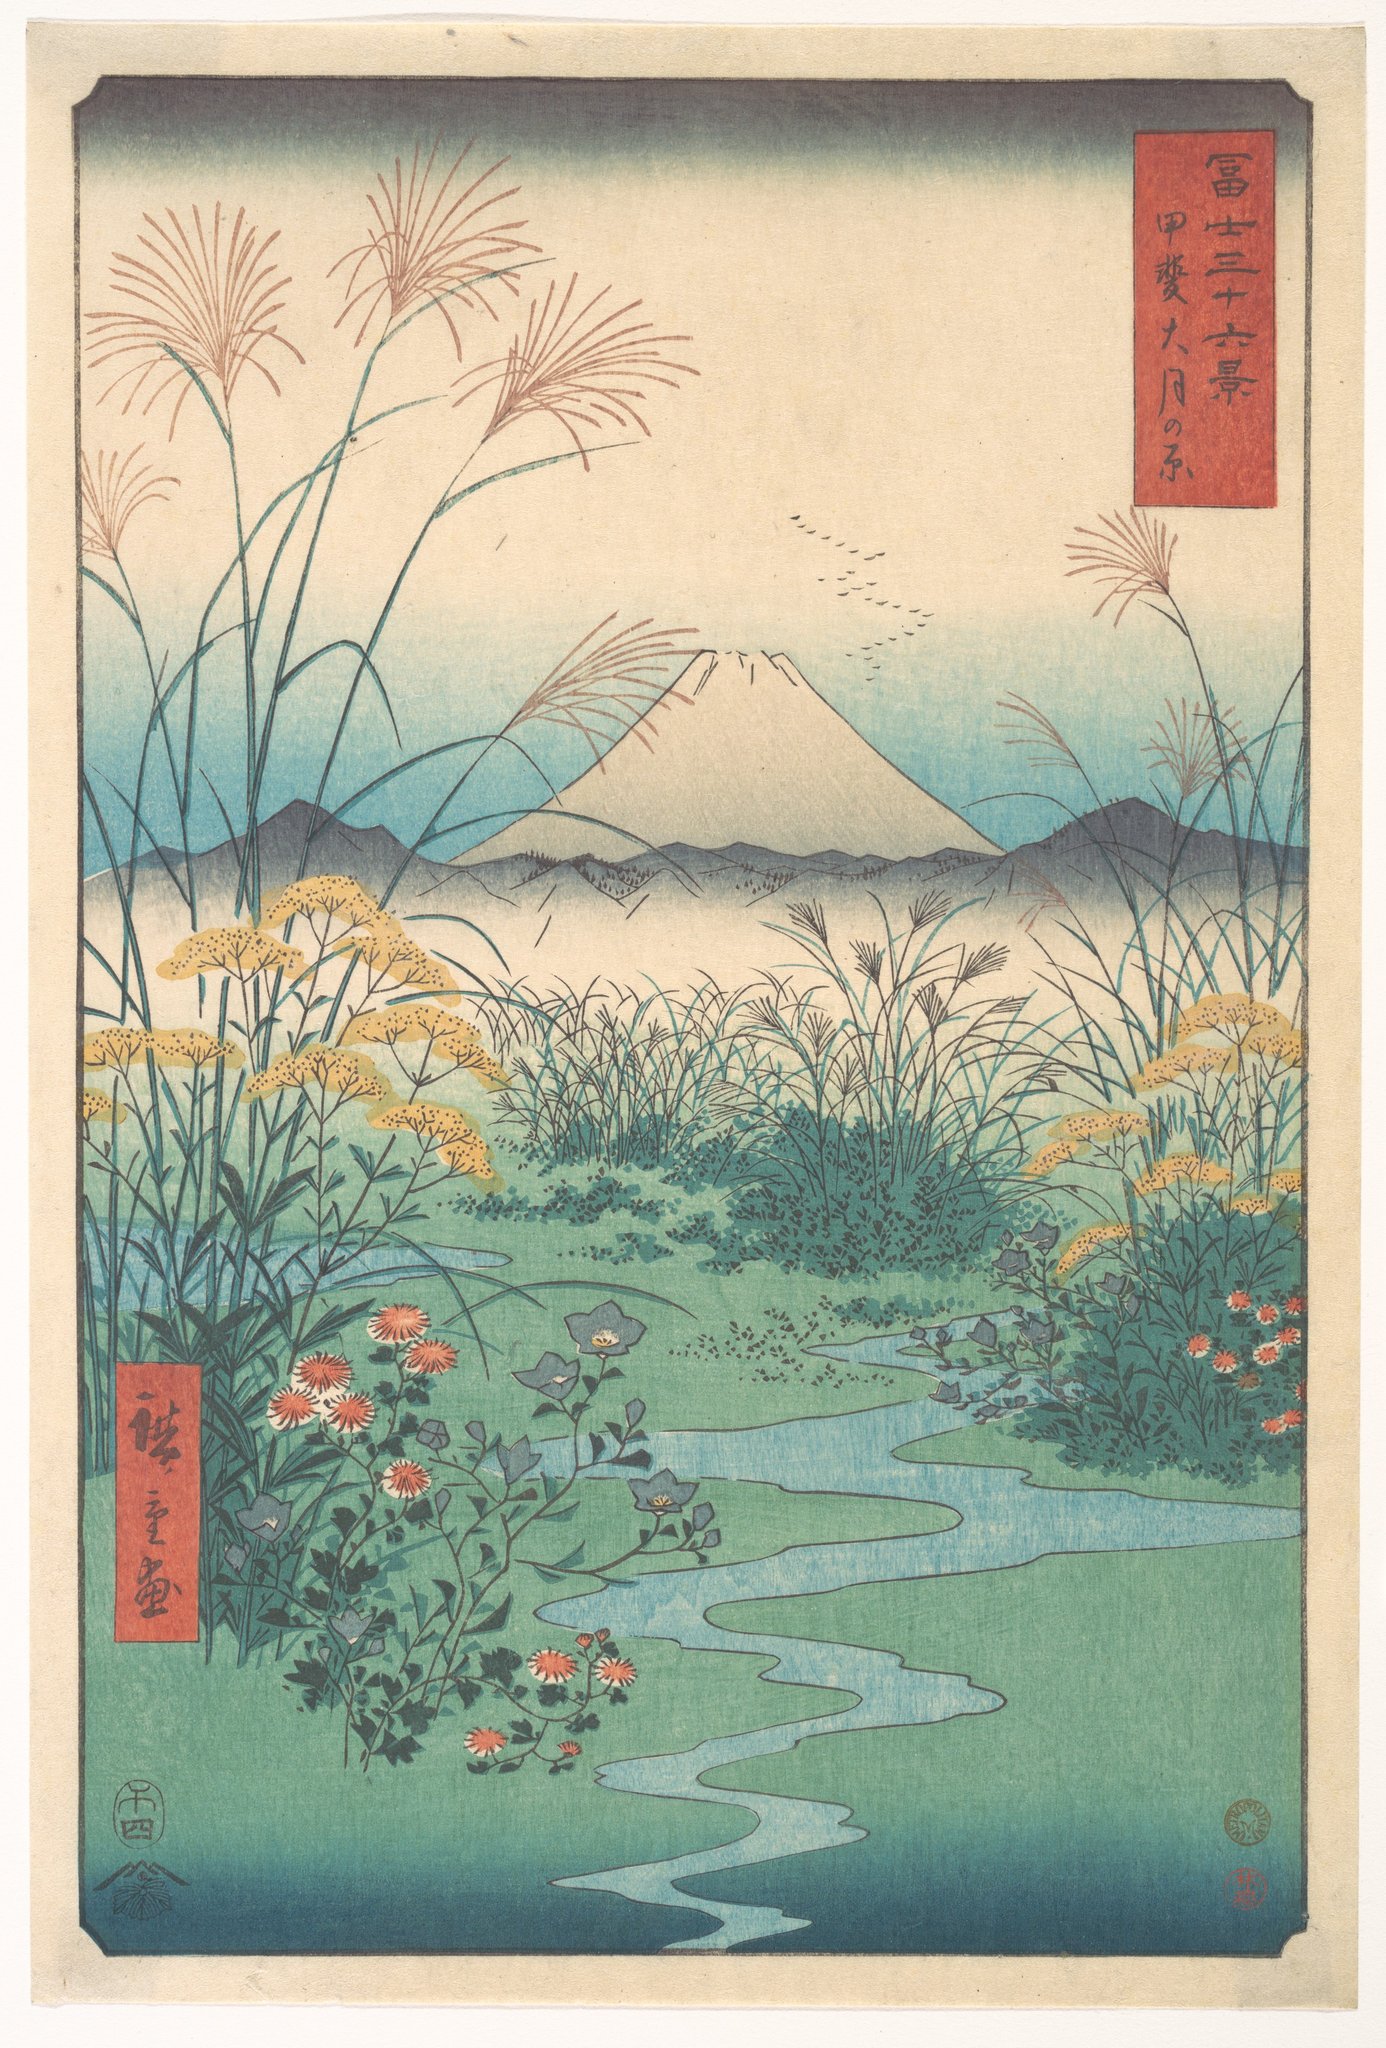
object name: print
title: Kai, Otsuki no Hara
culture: japanese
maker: utagawa hiroshige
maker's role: artist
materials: ink, paper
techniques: woodblock print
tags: flowers,mountains,landscapes